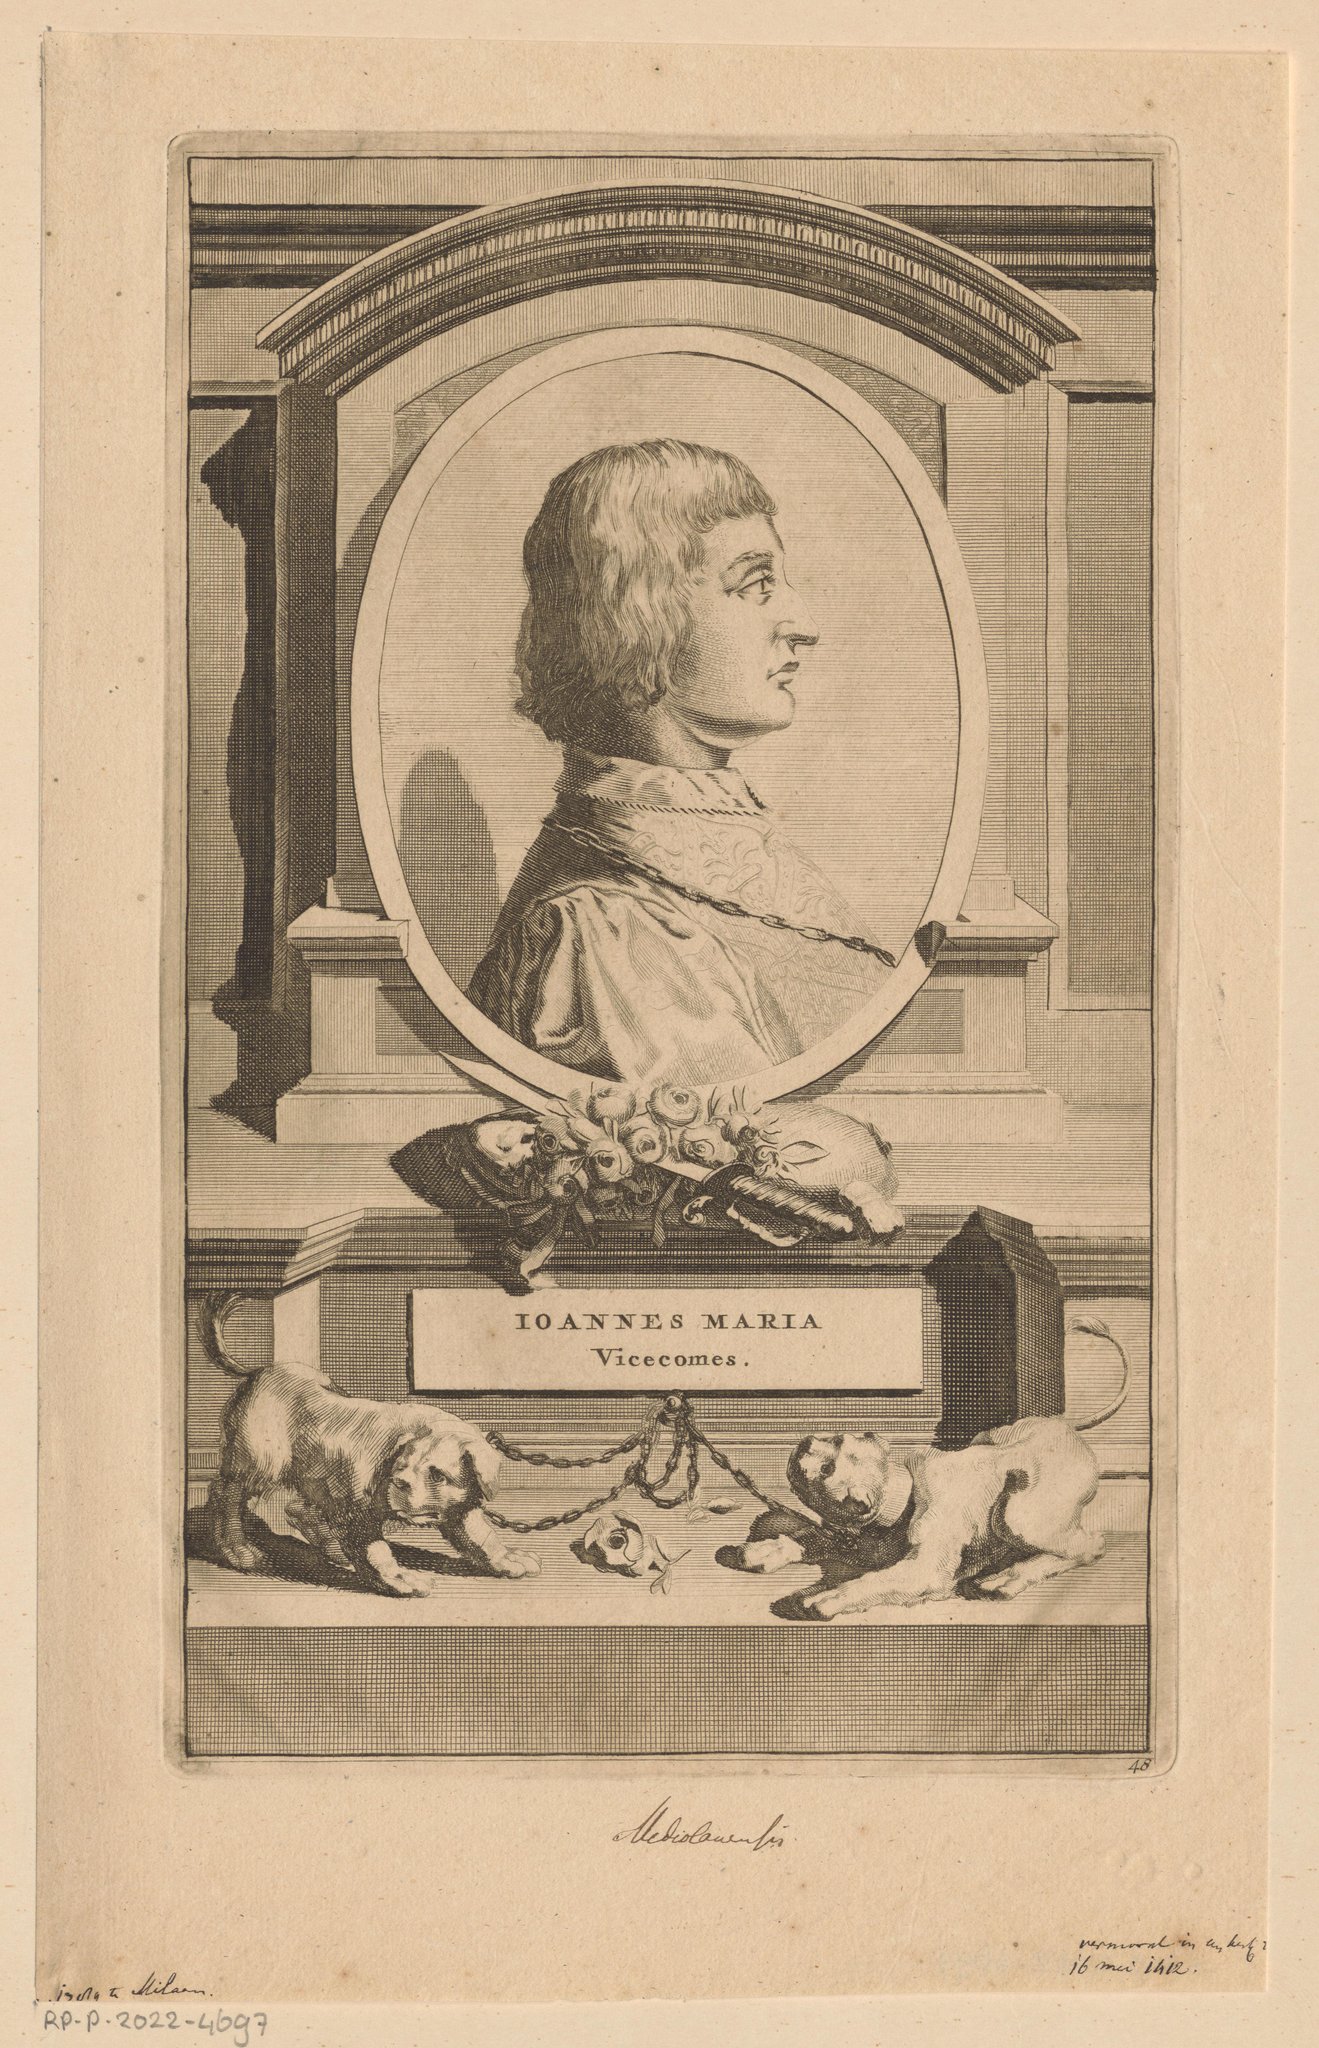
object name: print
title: Principum et illustrium quorundam virorum qui in Europa alibique terrarum quam fama quam eruditione celebres fuerunt, verae imagines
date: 1710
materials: paper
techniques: engraving, etching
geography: leiden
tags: historical persons, ruler, sovereign, dog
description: Prent waarschijnlijk uit: Principum et illustrium quorundam virorum qui in Europa alibique terrarum quam fama quam eruditione celebres fuerunt, verae imagines. Leiden: Pieter van der Aa, [ca. 1710]. Prent mogelijk ook gebruikt in: Graevius, Johannes Georg. Thesaurus Antiquitatum et Historiarum Italiae (...). Leiden: Pieter van der Aa, 1722, dl. 1-6. Eerdere staat gebruikt in de editie uit 1704.